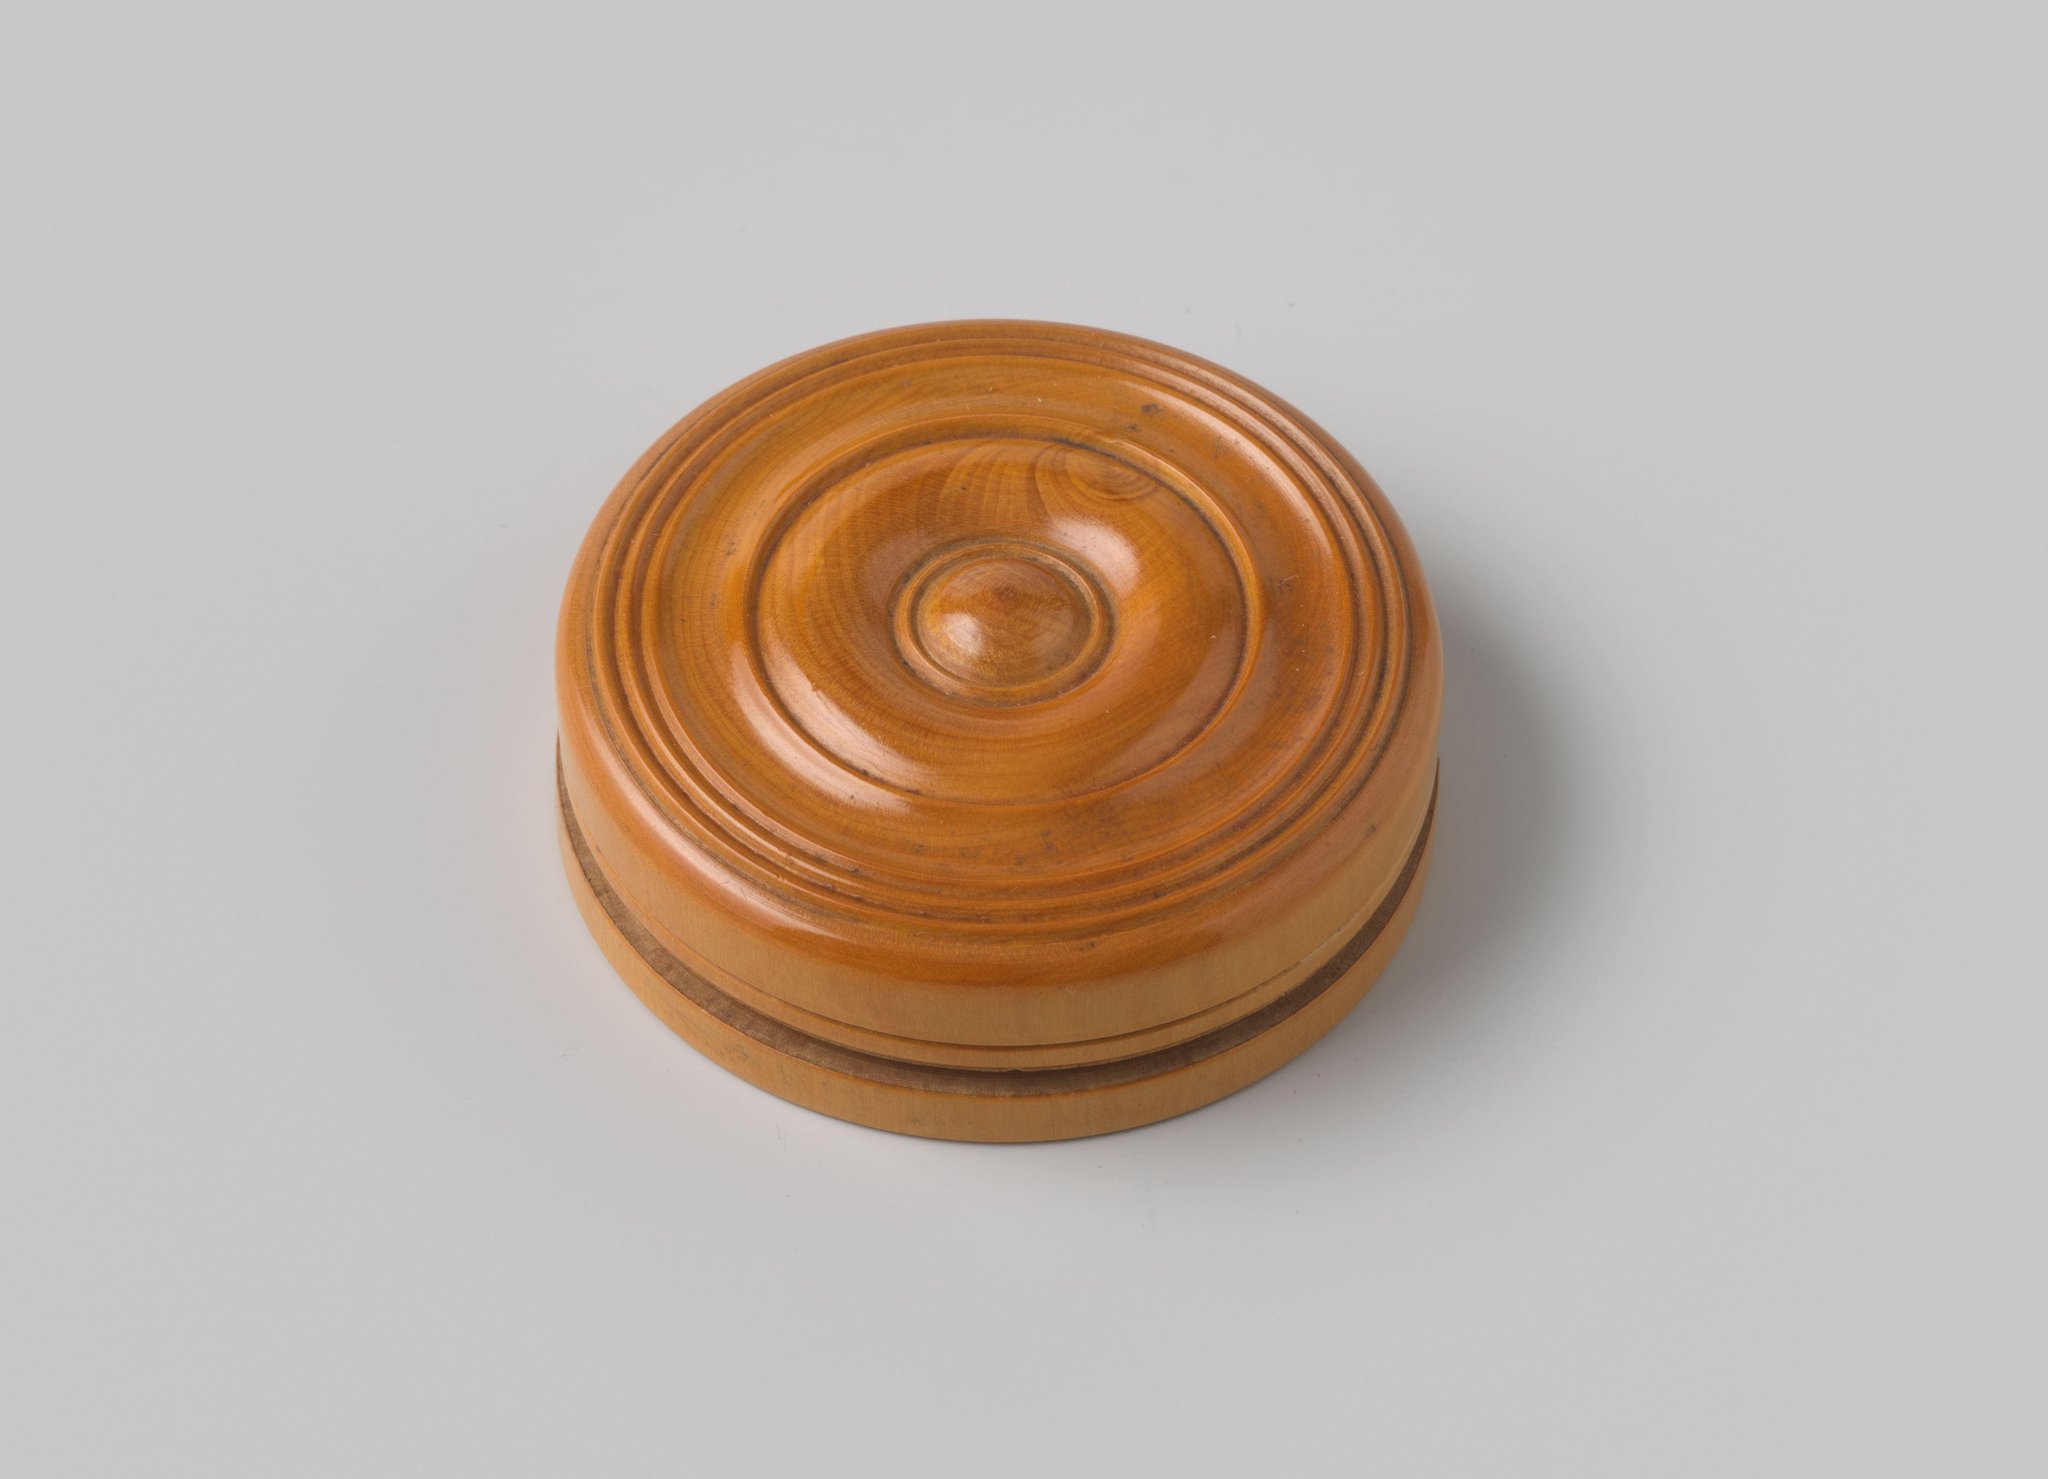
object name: medal box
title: Penningdoos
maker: Anonymous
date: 1879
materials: velvet, wood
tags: arnhem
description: Rond houten doosje met paars fluweel en draaideksel. Met bijbehorende penning NG-2001-17-C-1.